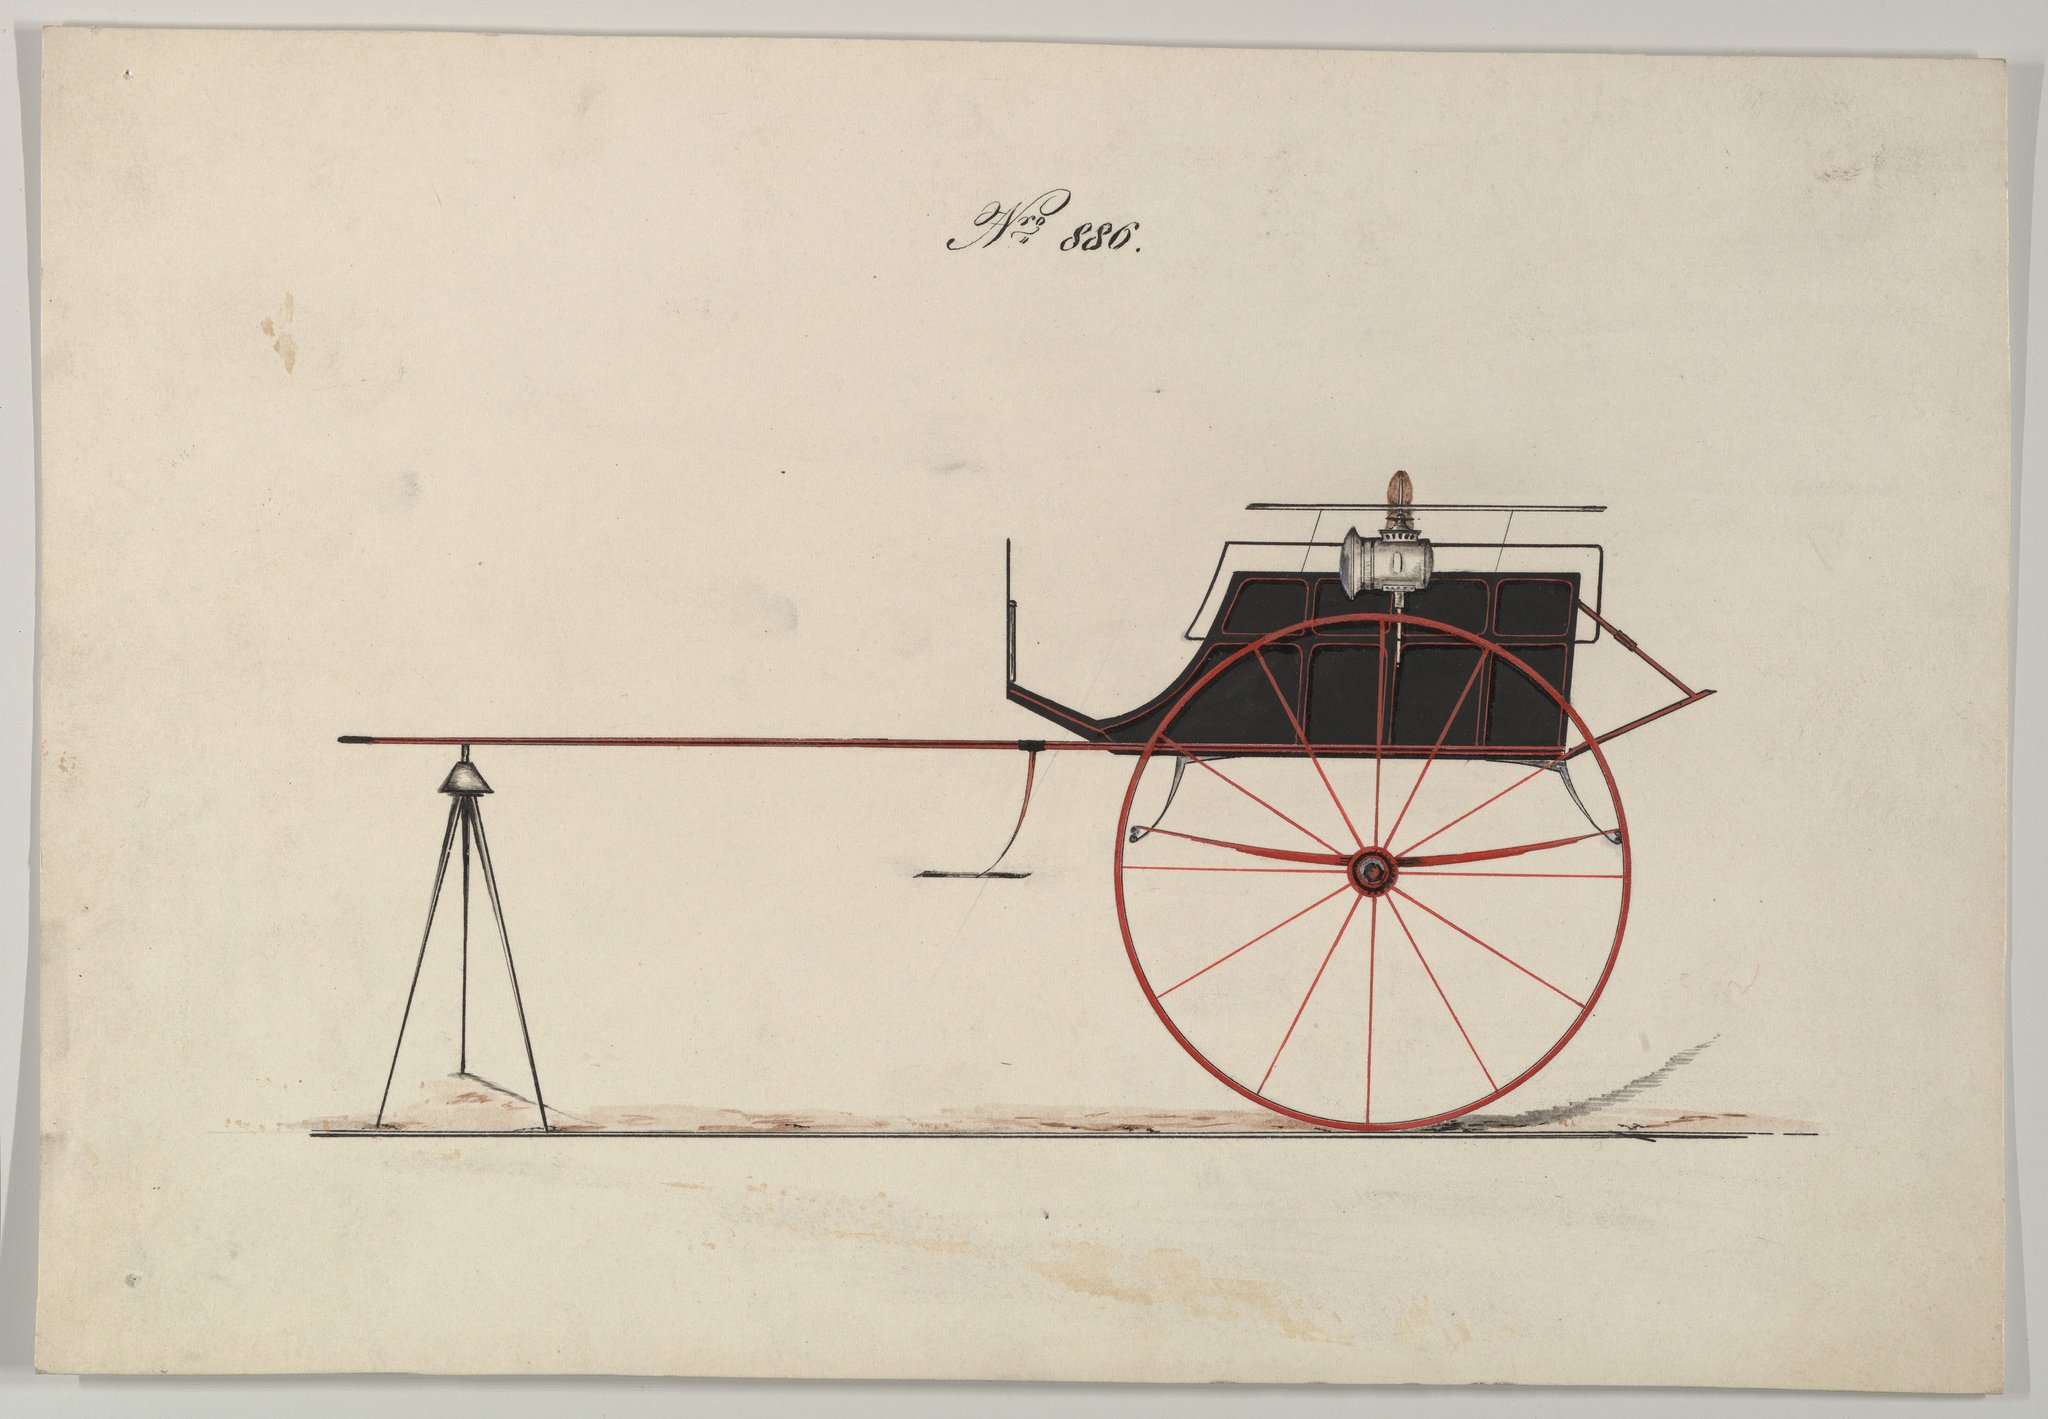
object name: drawing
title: Dog Cart # 886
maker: brewster & co.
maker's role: manufacturer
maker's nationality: american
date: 1870-1874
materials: gouache, gum arabic, ink, watercolor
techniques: pen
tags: carriages